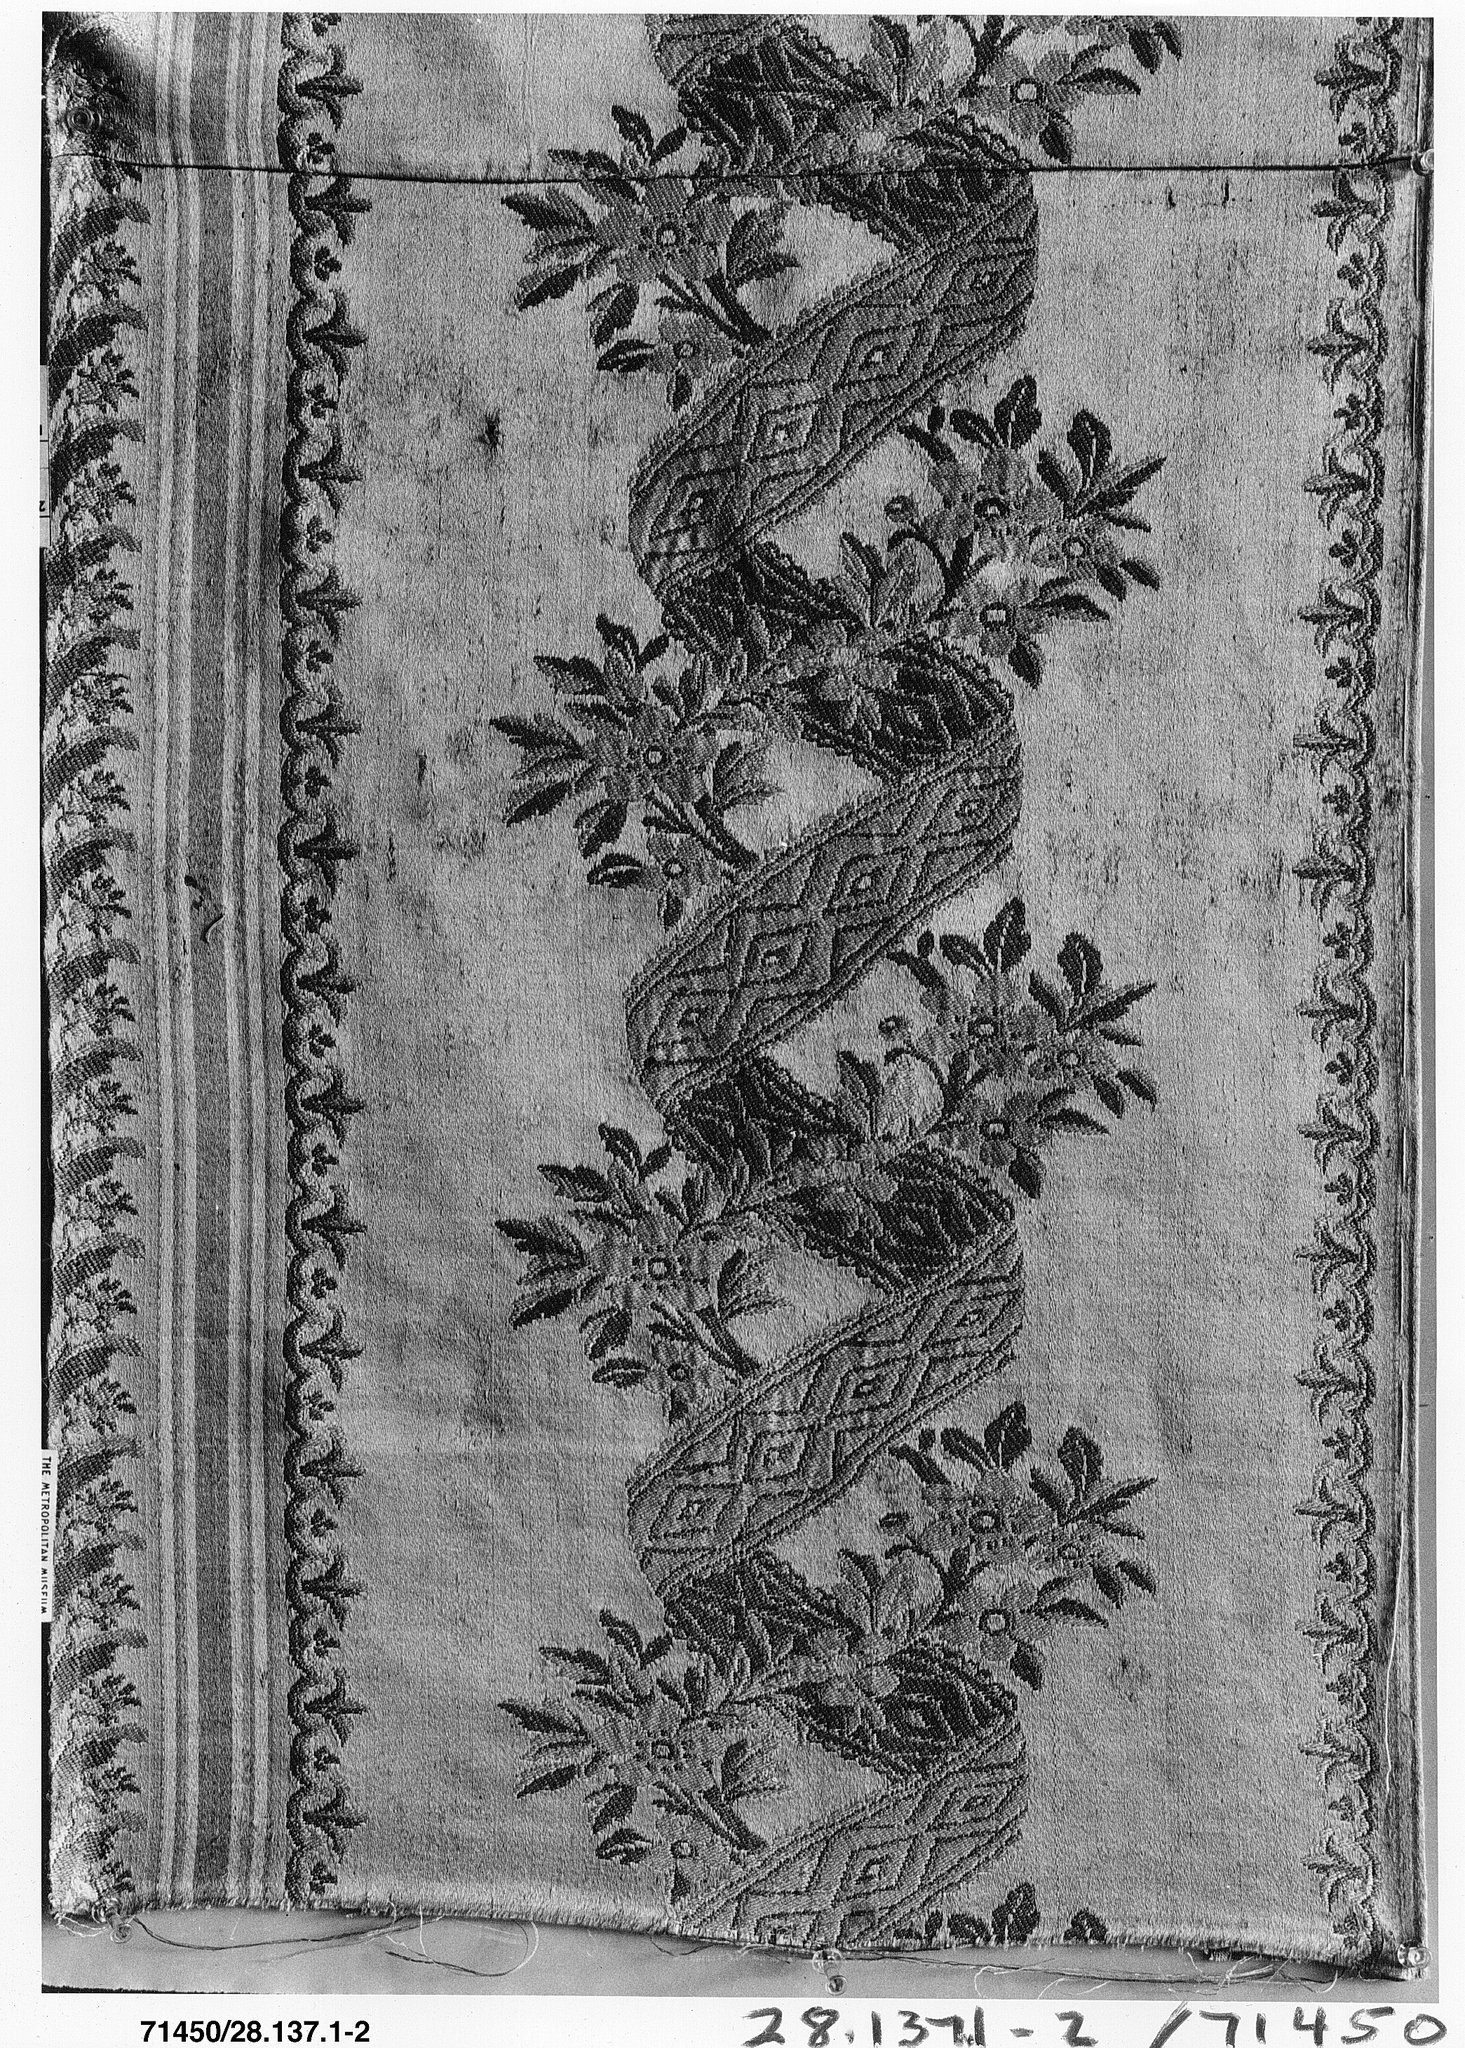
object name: piece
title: Pieces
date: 1701-1800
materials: silk